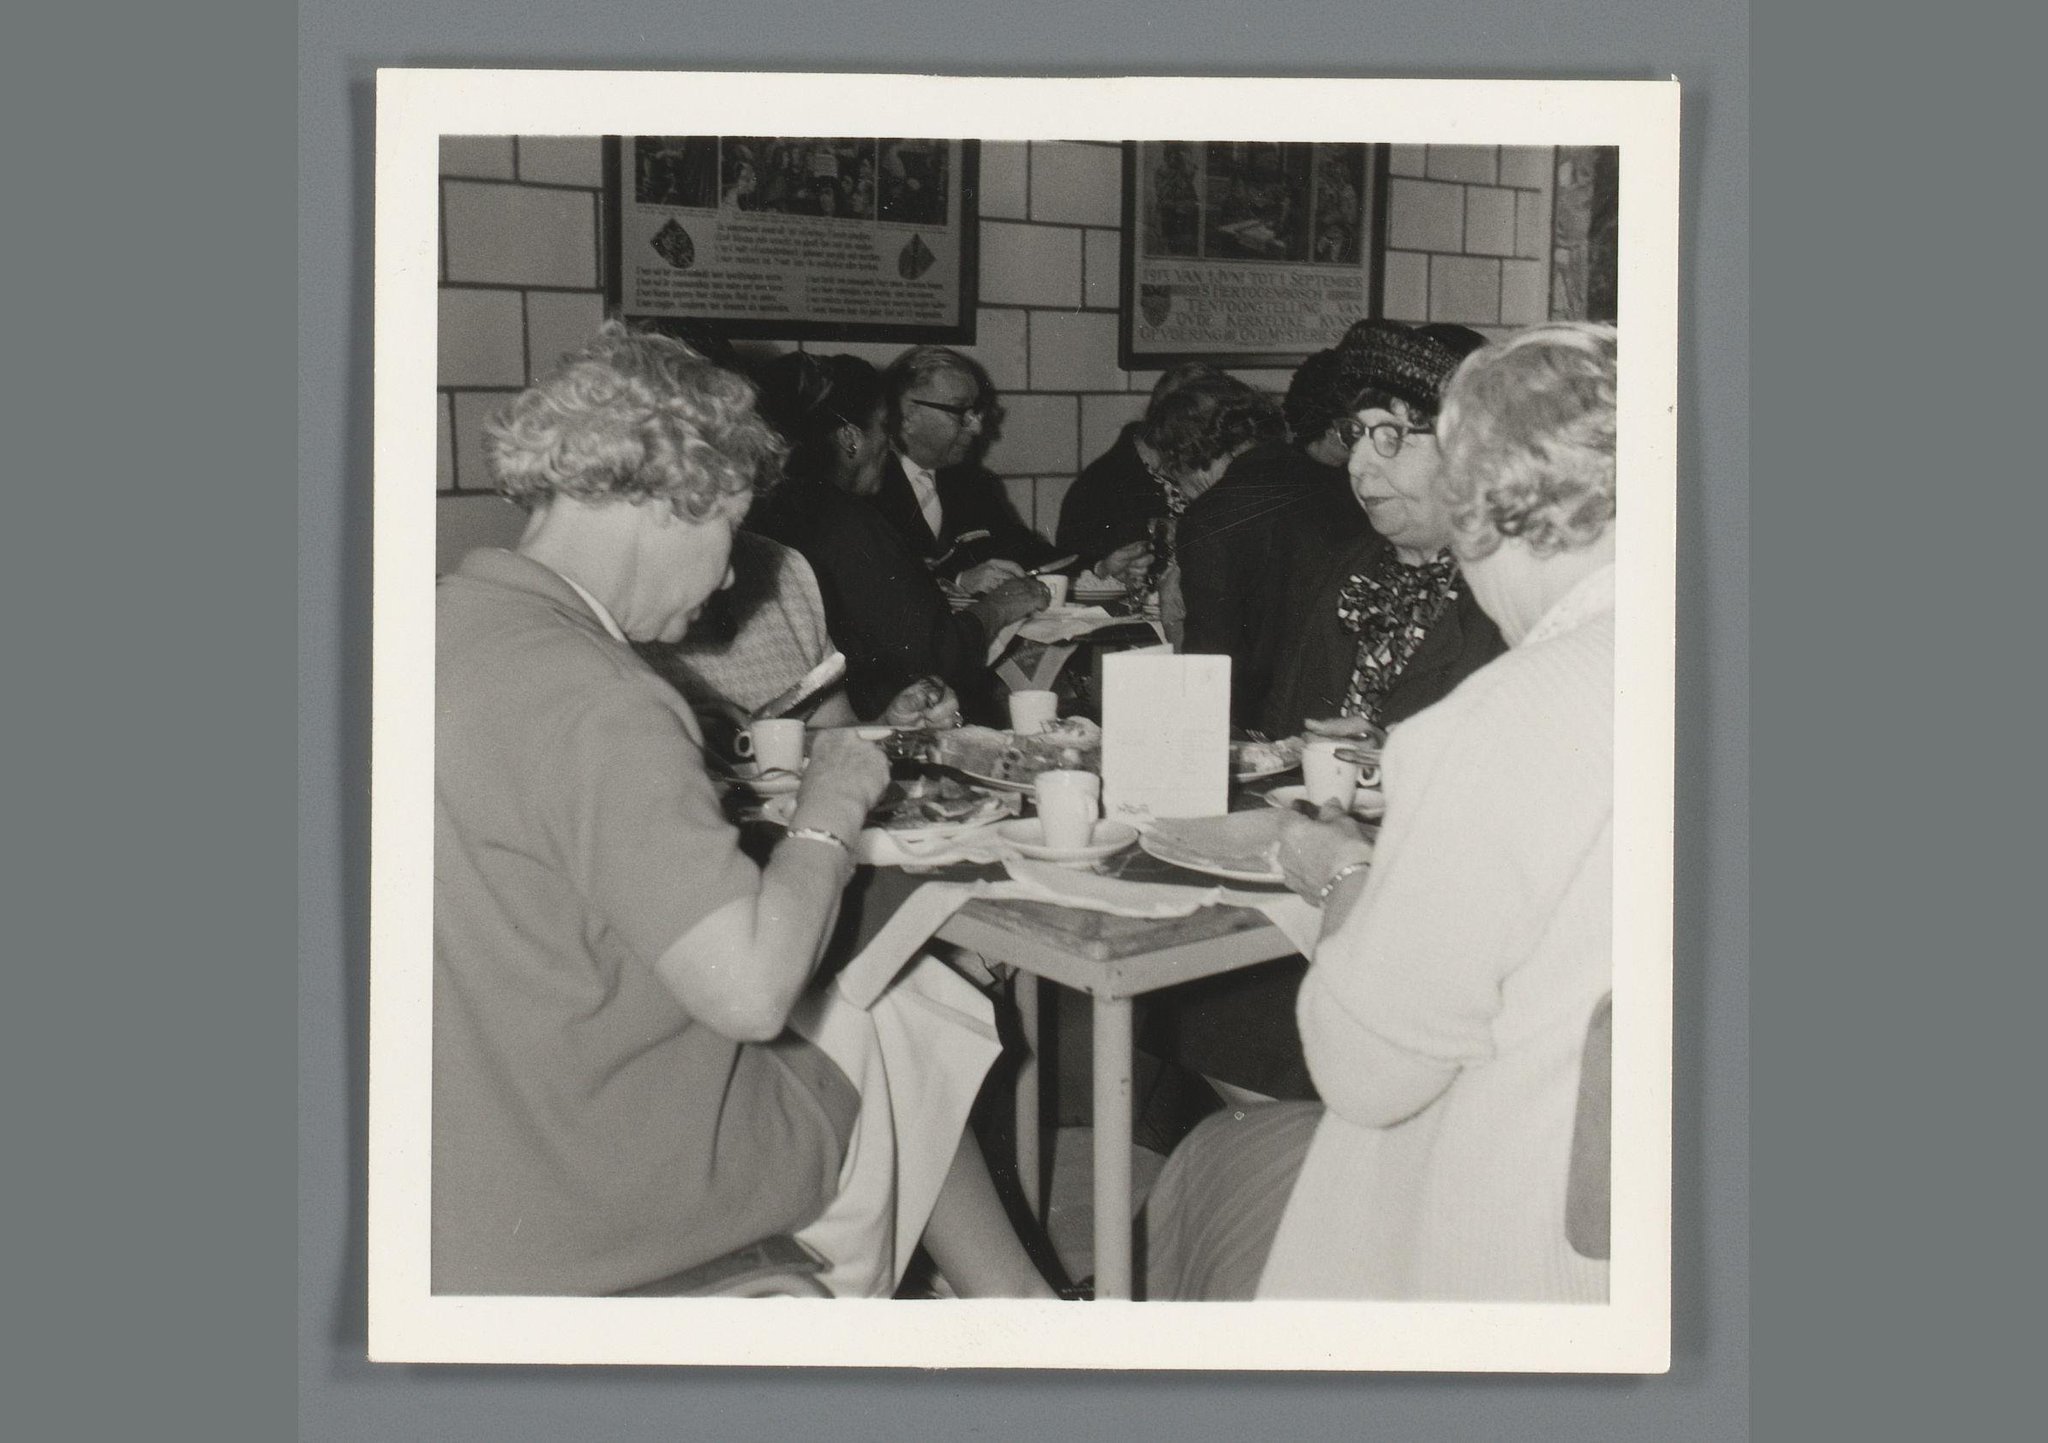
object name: photograph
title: Oudere mensen bij een maaltijd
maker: Anonymous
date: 1966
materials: paper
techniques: gelatin silver print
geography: den bosch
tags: midday meal, lunch, den bosch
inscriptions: date: ‘15.8.66’, number: ‘707A’